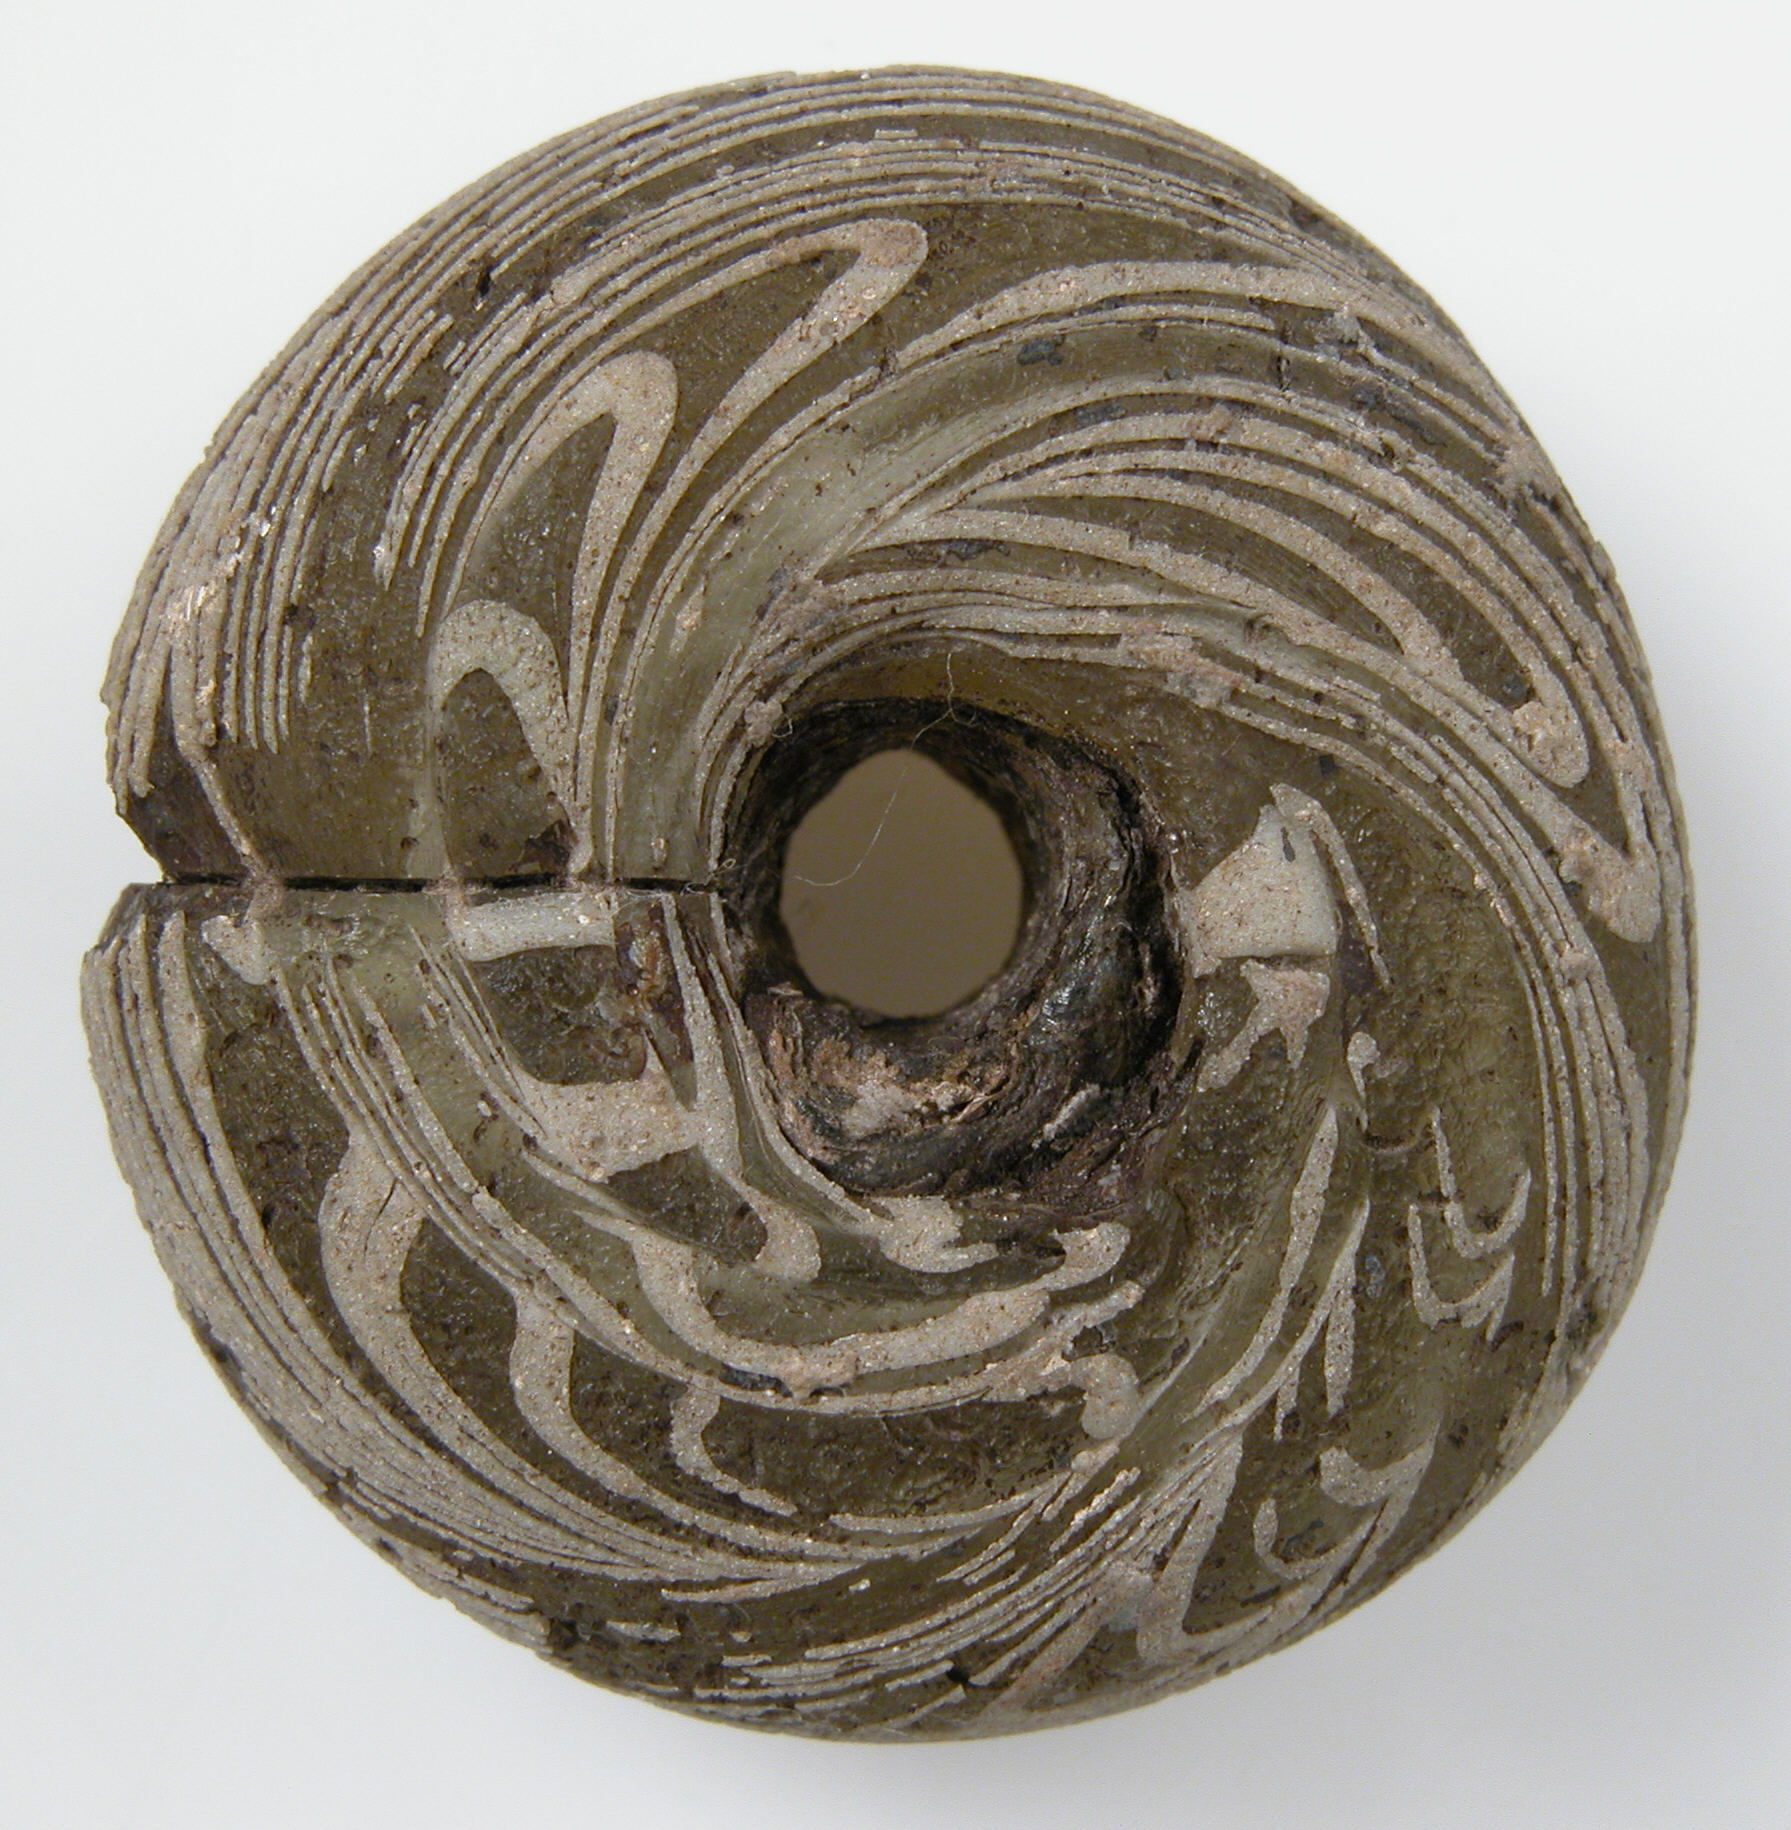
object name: bead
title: Circular Bead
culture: frankish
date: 500-600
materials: glass